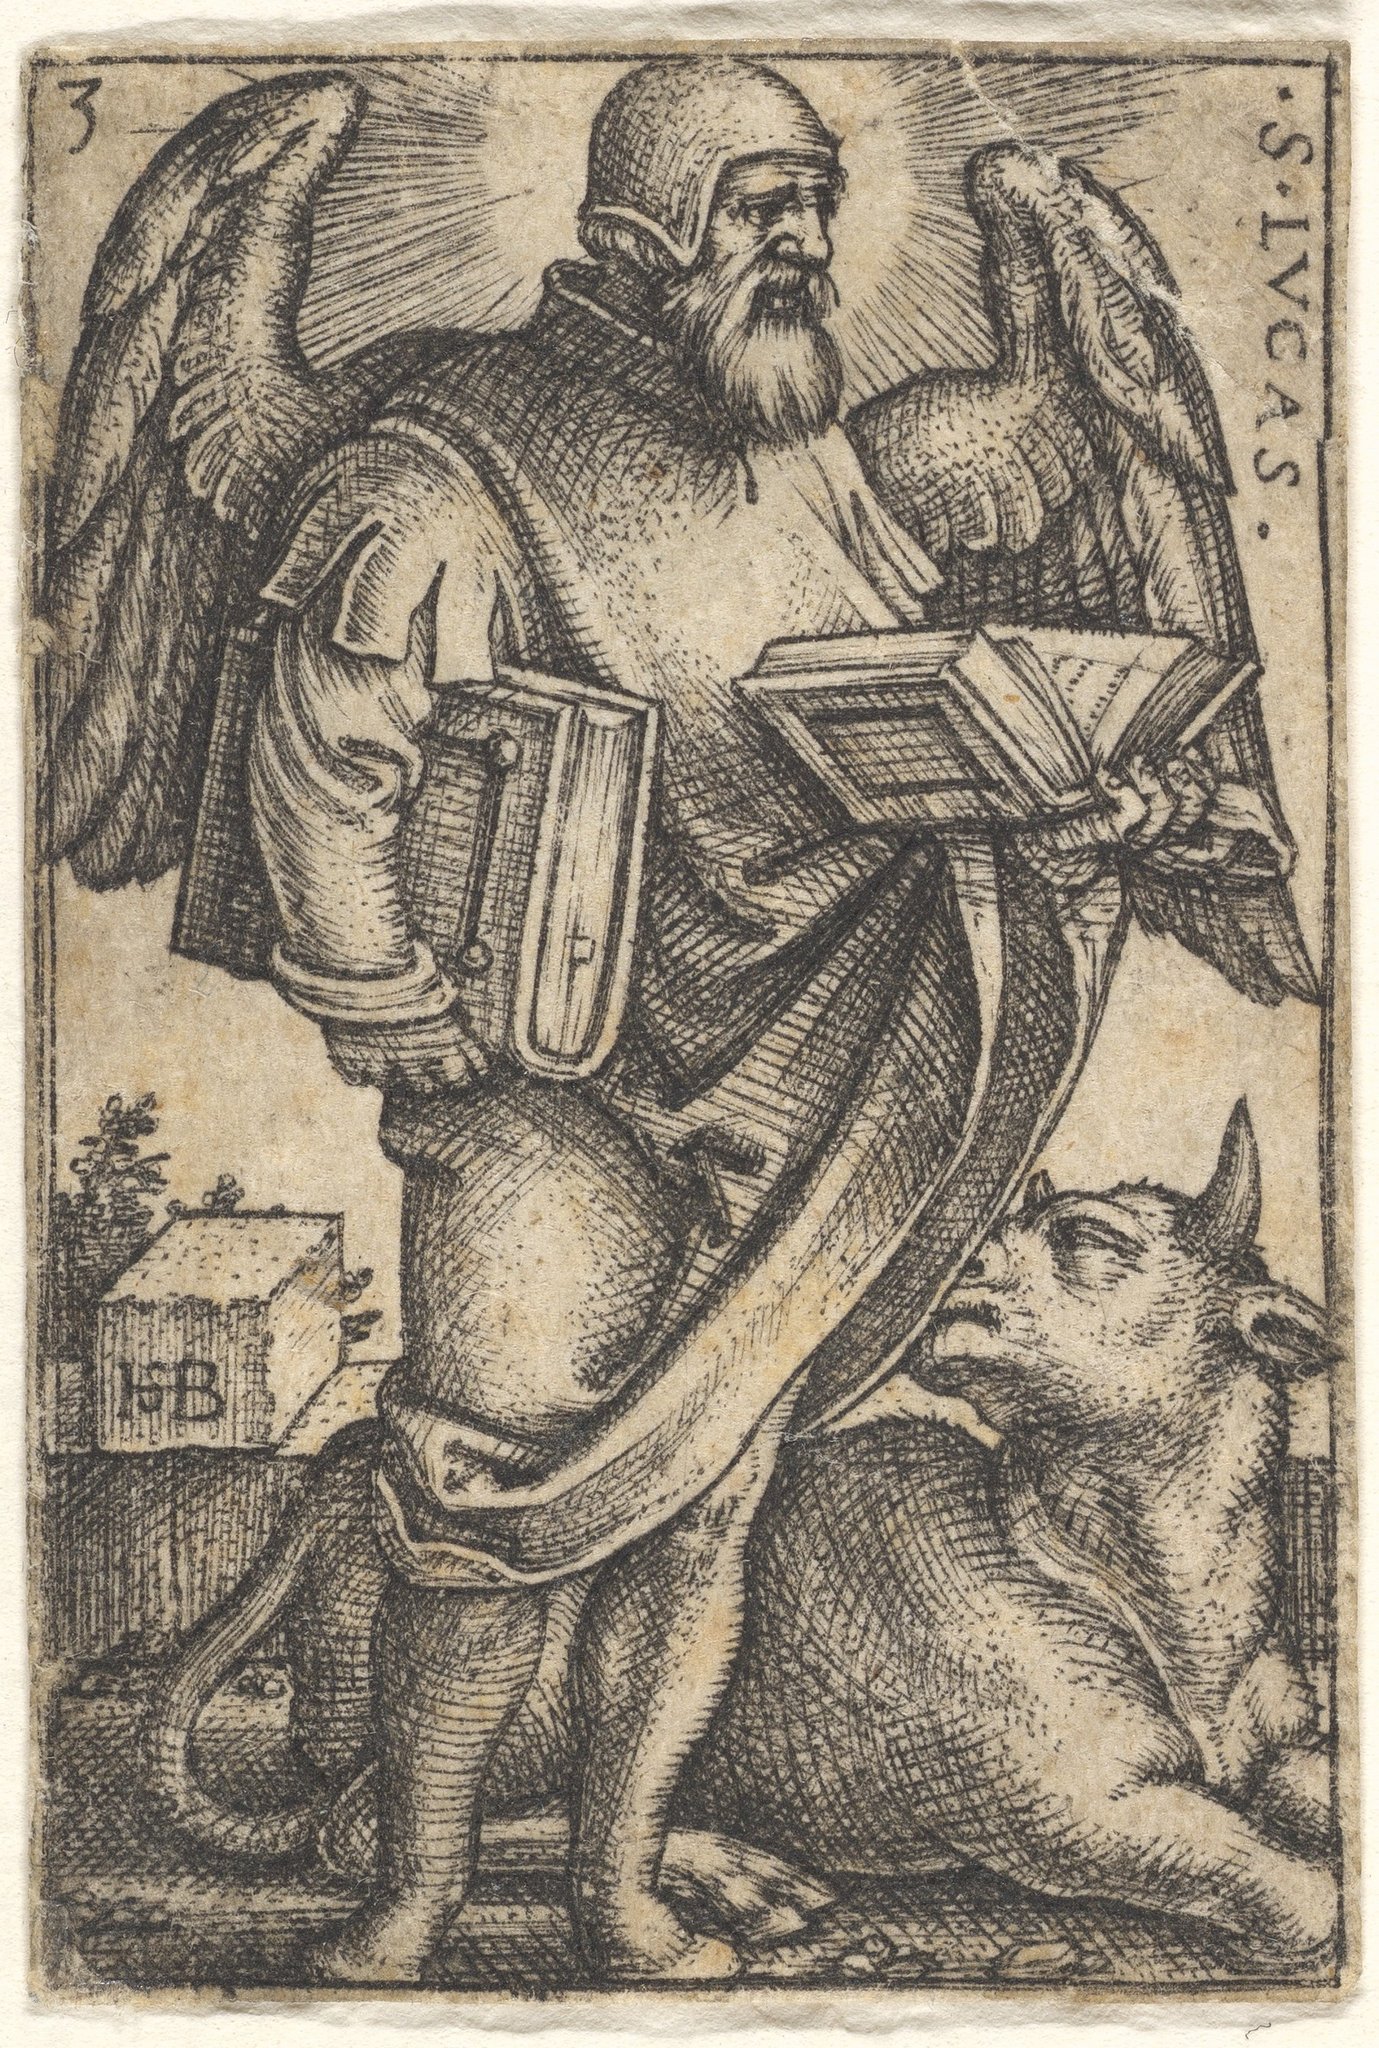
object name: print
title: Saint Luke with his head turned in profile to the right, a book in each hand, a bull at his feet, plate 3 from "The Four Evangelists"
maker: sebald beham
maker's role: artist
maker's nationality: german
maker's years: 1500-1550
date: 1541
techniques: engraving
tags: books,bulls,saints